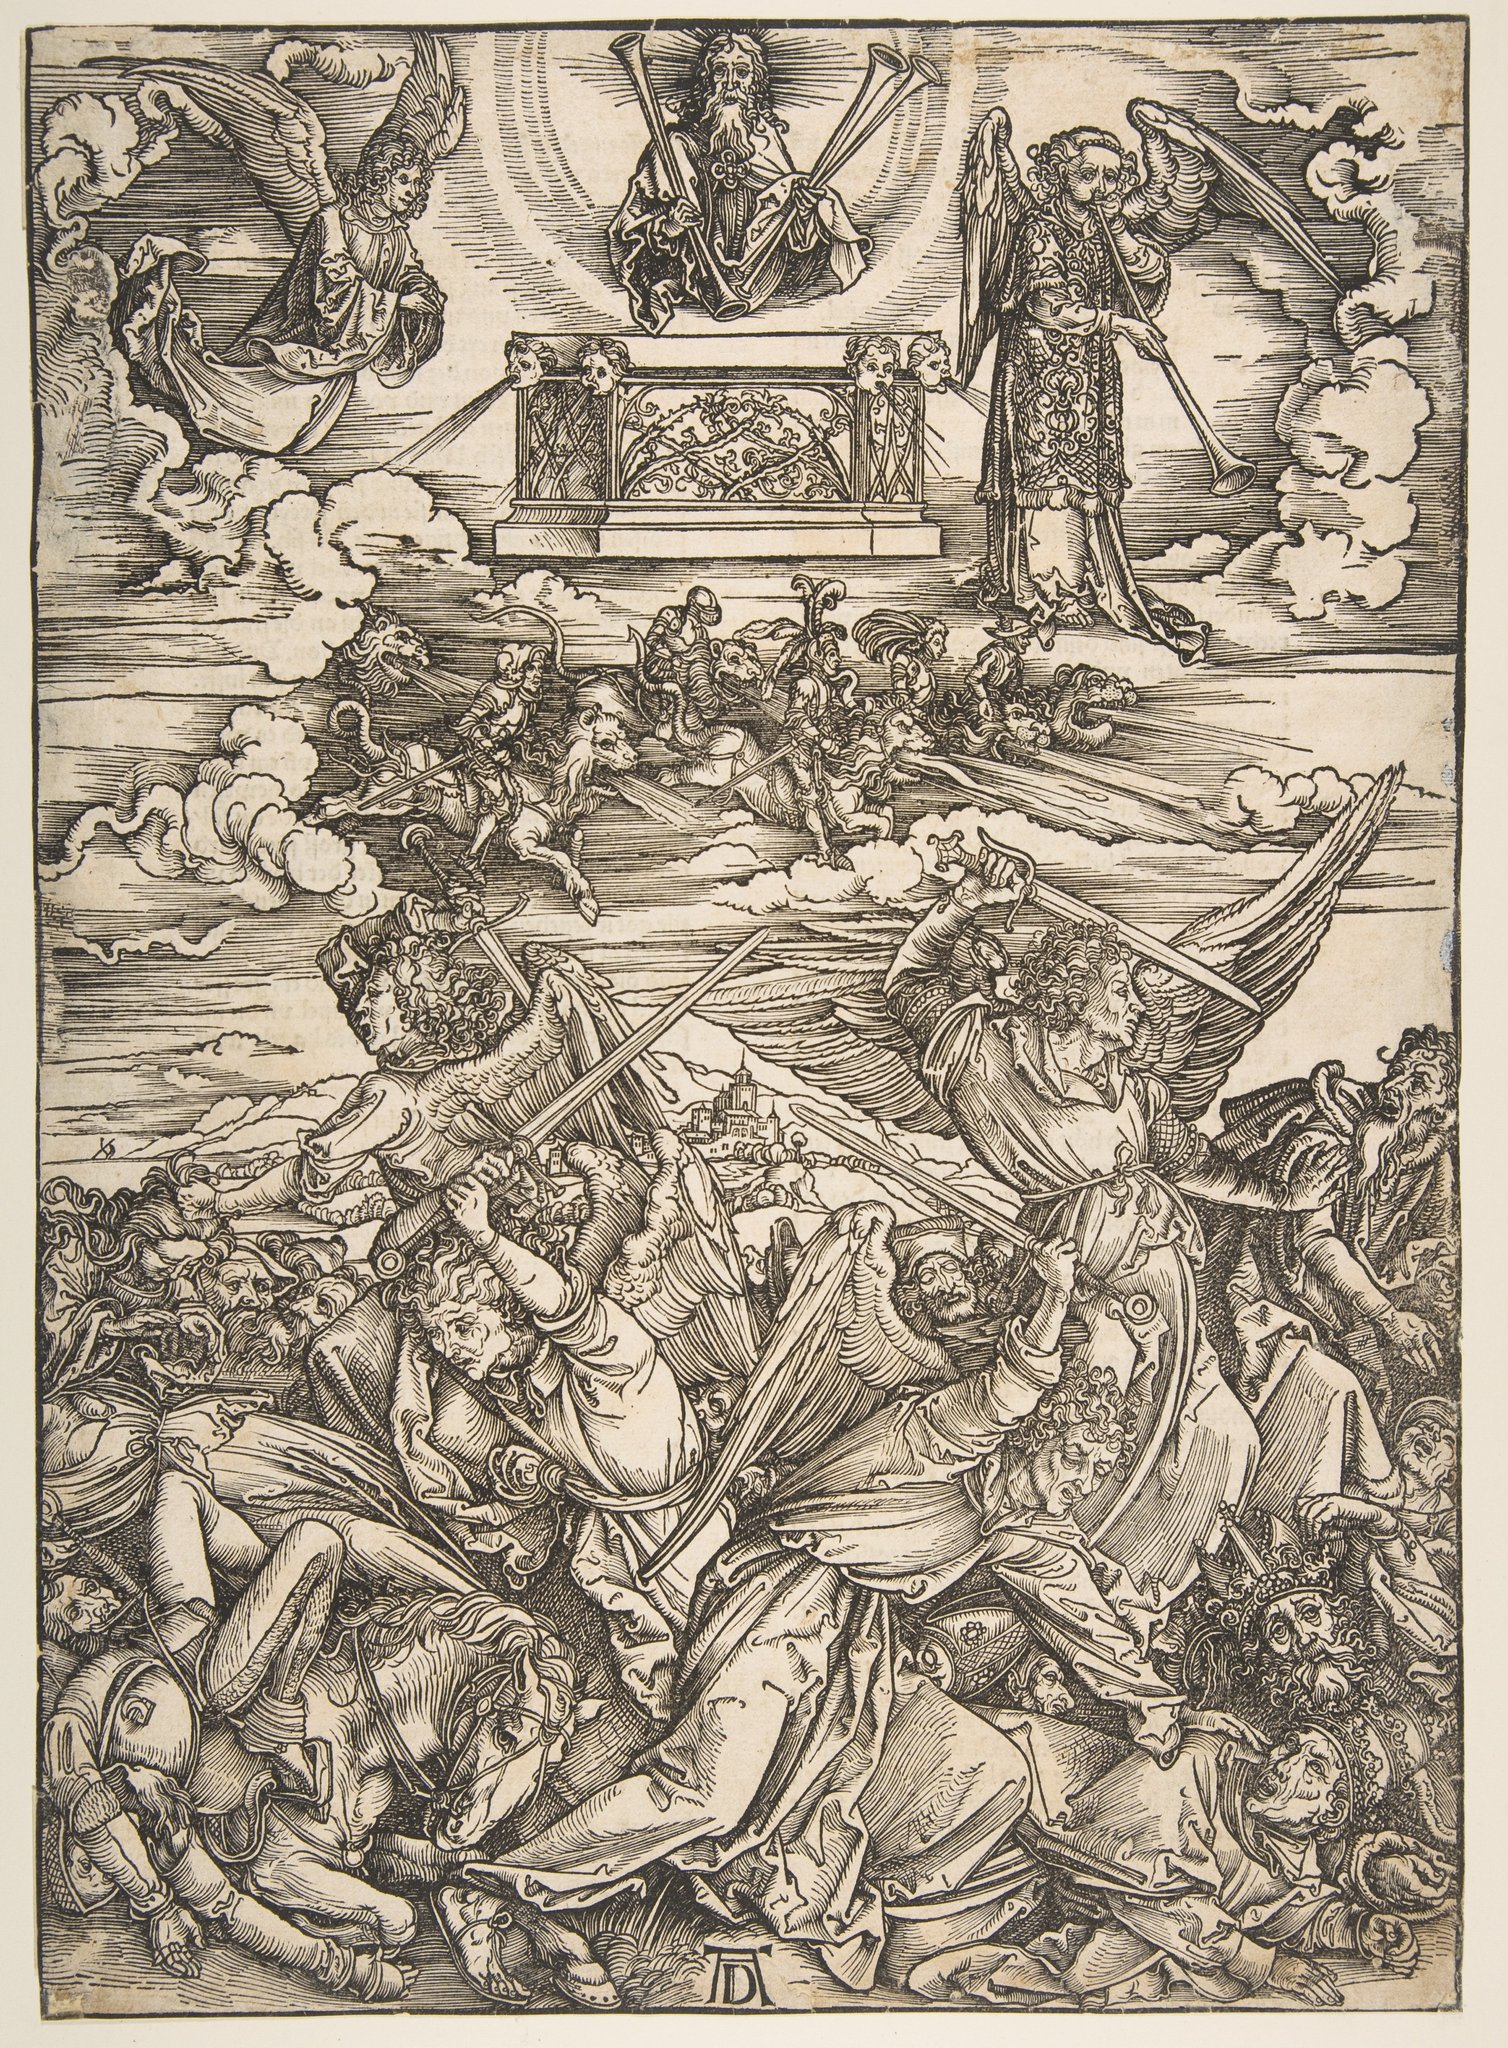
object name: print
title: The Four Avenging Angels, from "The Apocalypse"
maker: albrecht dürer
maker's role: artist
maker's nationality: german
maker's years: 1471-1528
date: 1498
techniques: woodcut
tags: battles,horses,angels,apocalypse